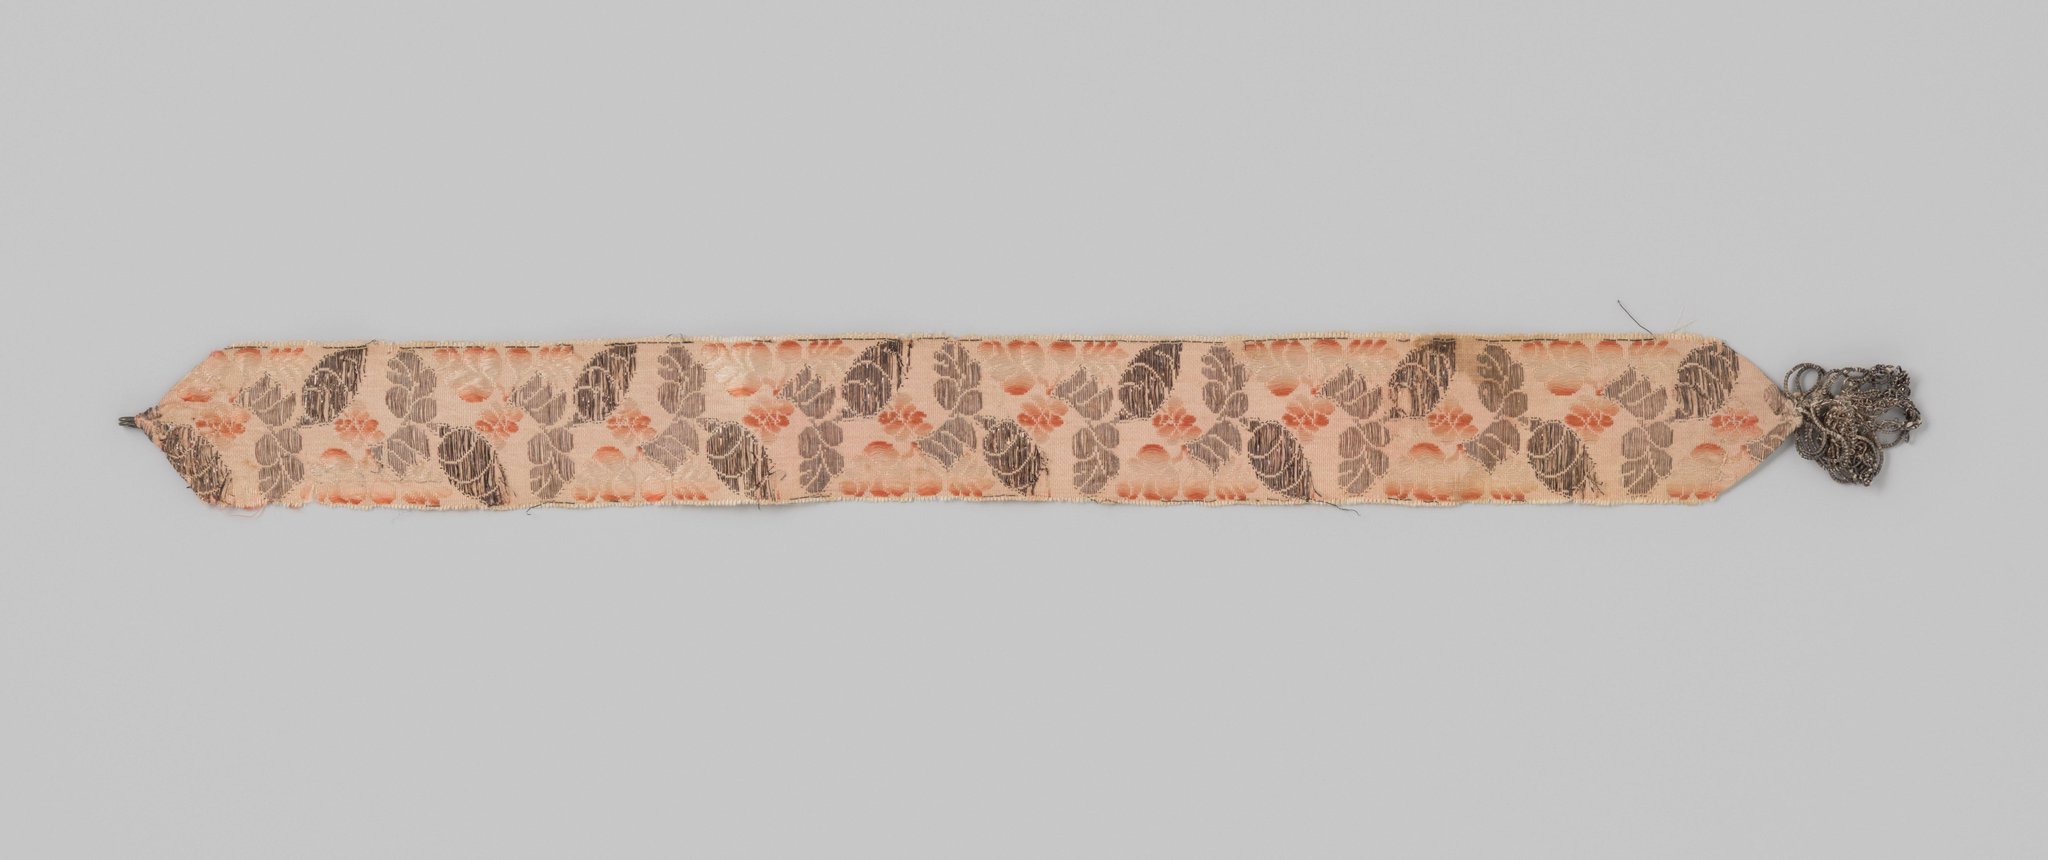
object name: garter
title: Kousenband van beige zijde met lancé-effect; de kousenband is versierd met bloemen en bladeren in zilver en oranje; met zilveren torsade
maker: Anonymous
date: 1700-1800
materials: silk, silver, thread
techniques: weave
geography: netherlands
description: Kousenband van beige zijde met lancé-effect. De kousenband is versierd met bloemen en bladeren in zilver en oranje. Aan één van de korte kanten is een zilveren torsade bevestigd; aan de andere een haak.